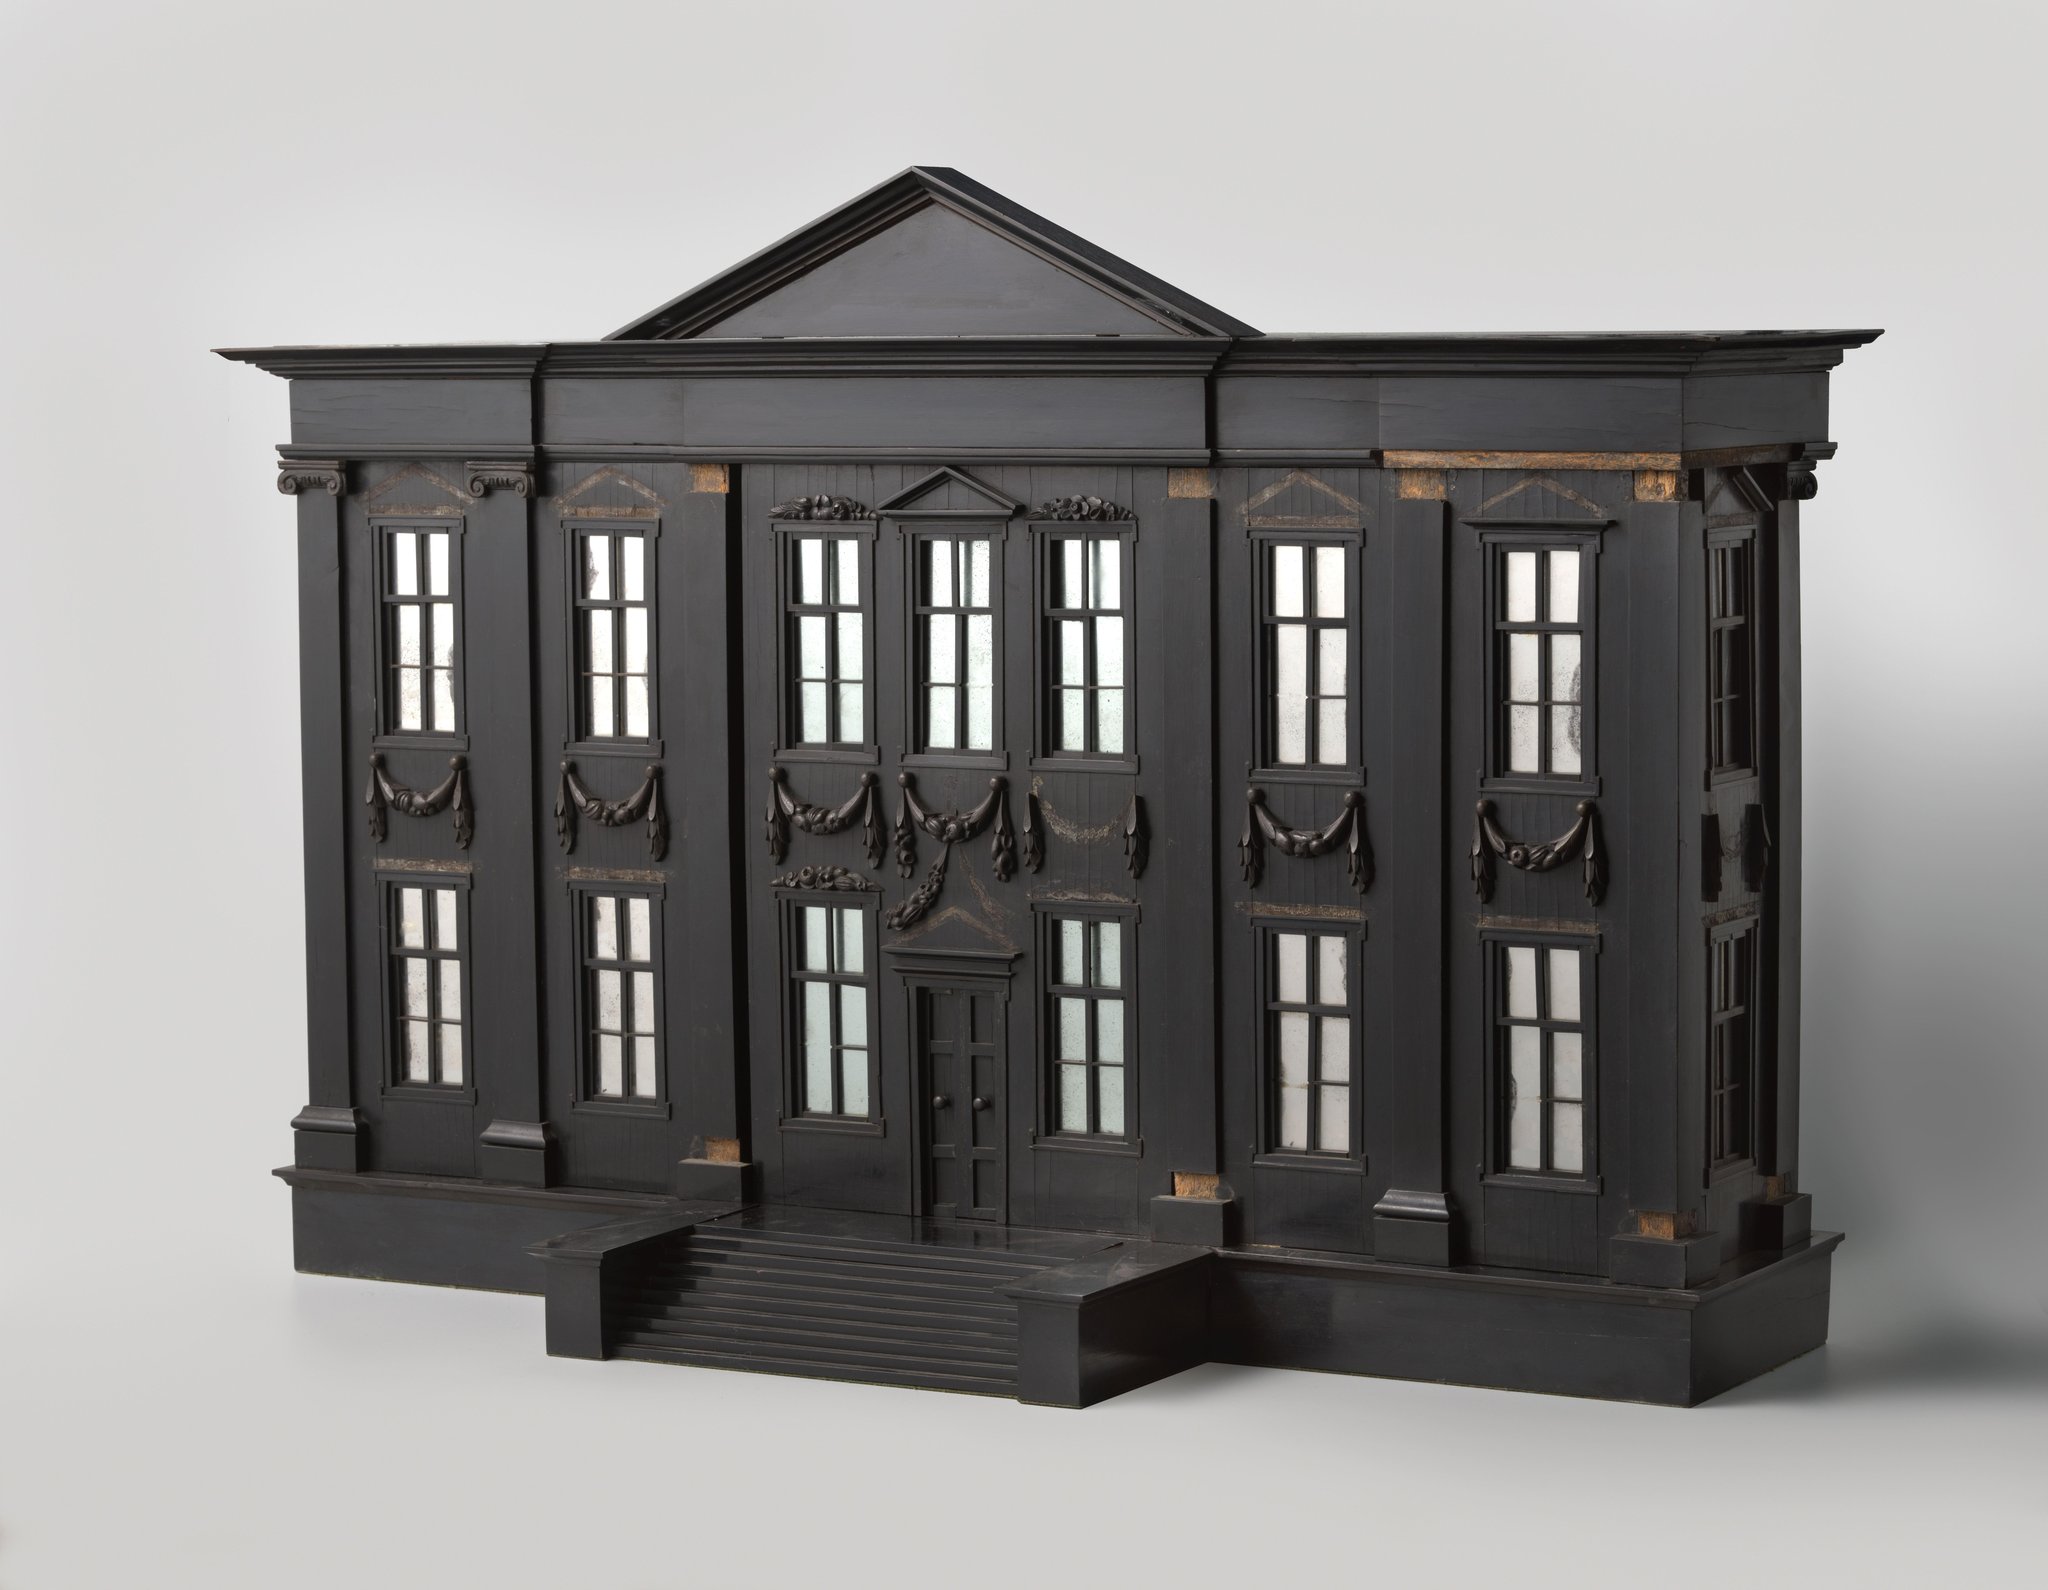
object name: case furniture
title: Medaillekast in de vorm van Mauritshuis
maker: Anonymous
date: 1800-1900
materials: wood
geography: northern netherlands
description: Medaillekast van ebbenhout met spiegelglas in de vorm van de voorgevel van het Mauritshuis te 's Gravenhage.